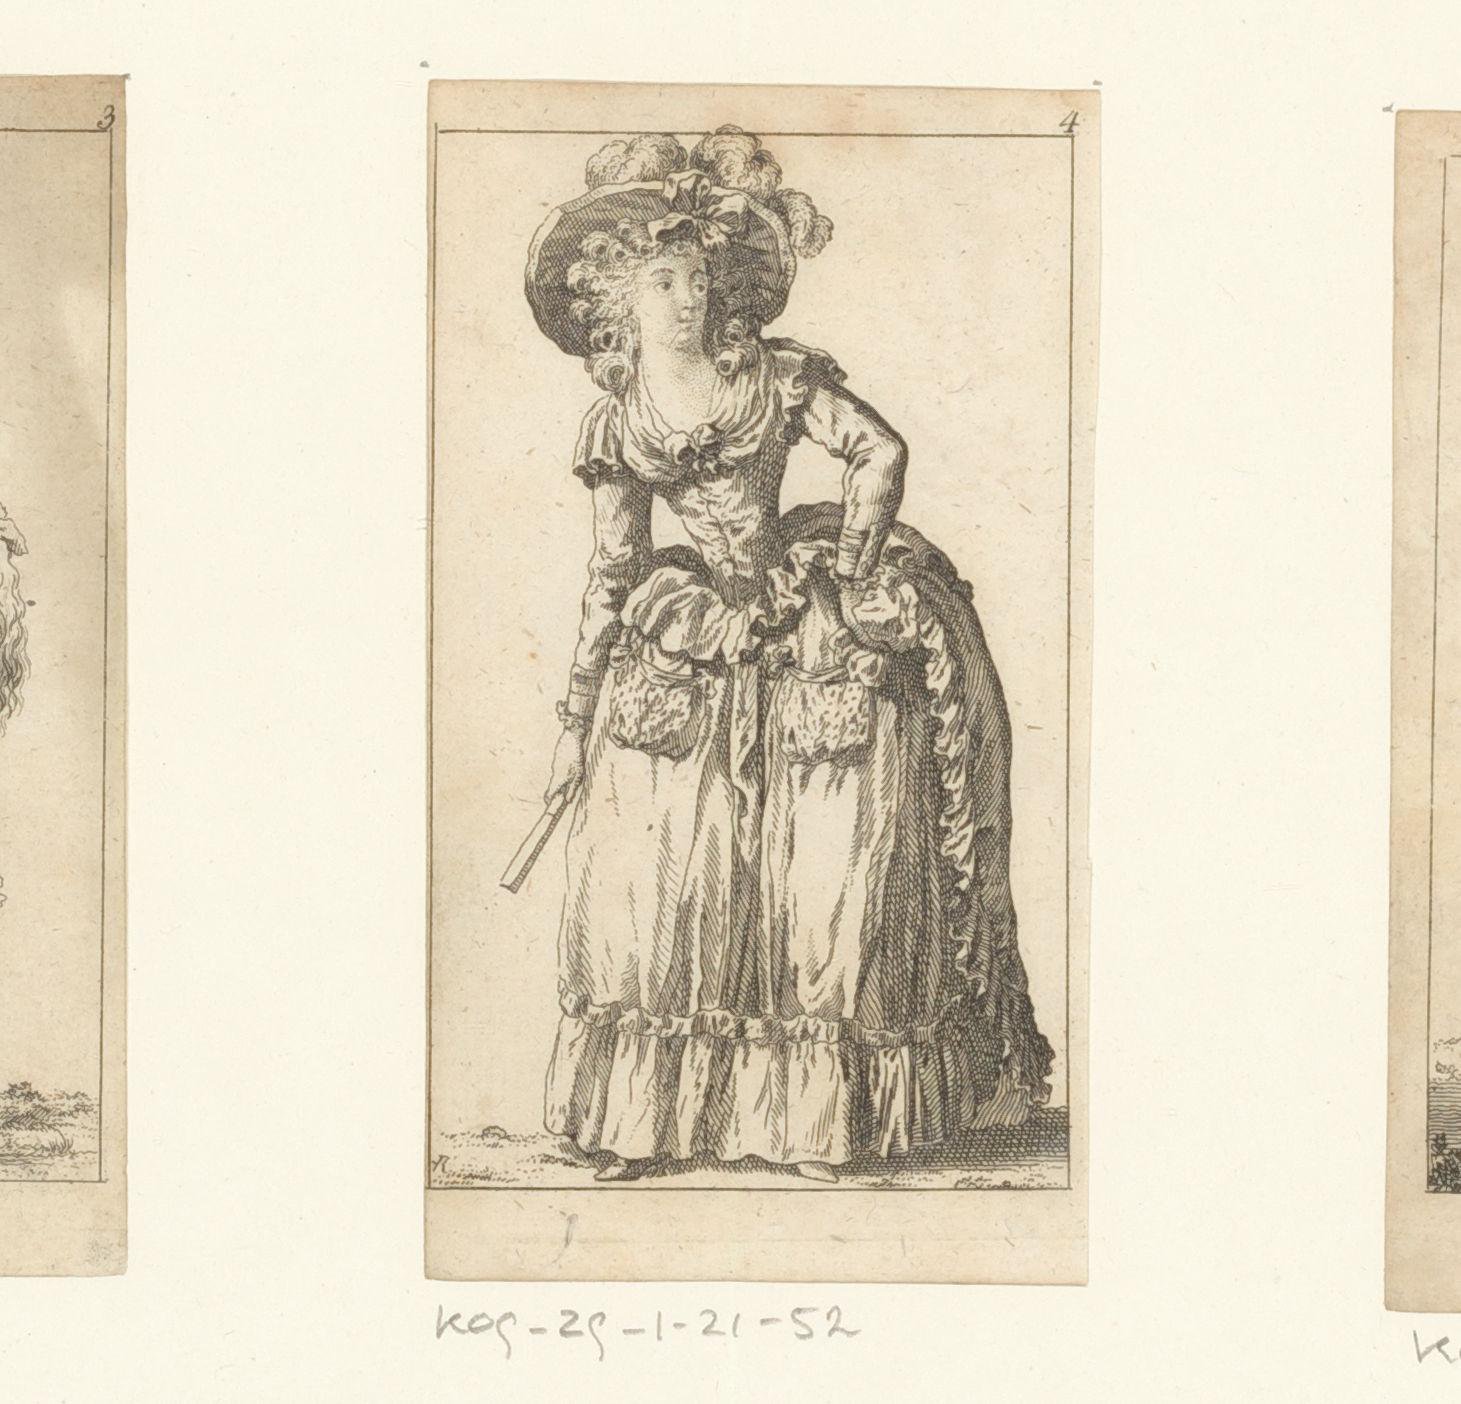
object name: print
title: Staande vrouw met waaier in haar hand en hand in haar zij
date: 1780-1840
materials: paper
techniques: etching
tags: fan, head-gear: hat, dress, gown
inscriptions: collector's mark: Lugt 1641, stamp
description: Rechtsboven genummerd: 4. Onderwerpsrubrieken binnen de Atlas Zeden en Gewoonten: Zeden en Gewoonten in Engeren Zin, De Kleeding, Kleederdrachten (tijdvakken), De 18de eeuw (de pruikentijd). Mannen en vrouwen.